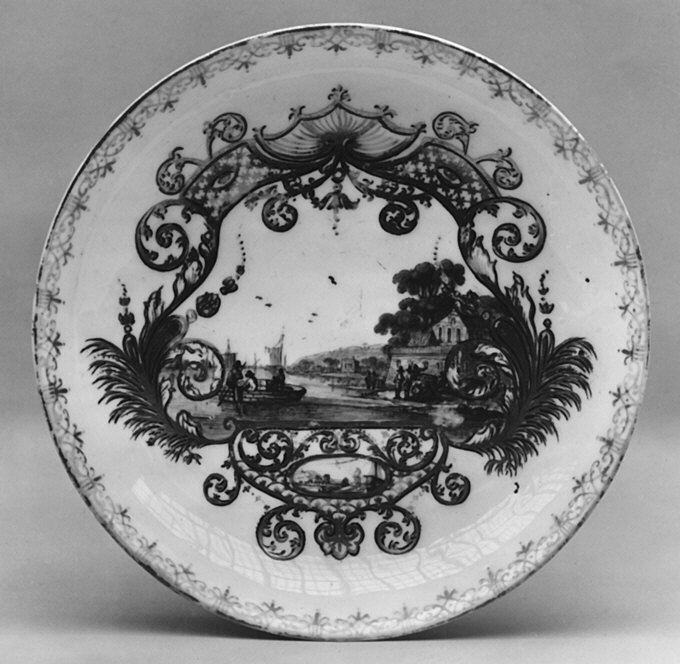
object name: saucer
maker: meissen manufactory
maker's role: manufactory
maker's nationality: german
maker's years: 1710-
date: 1740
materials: hard paste porcelain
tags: houses,landscapes,trees,boats